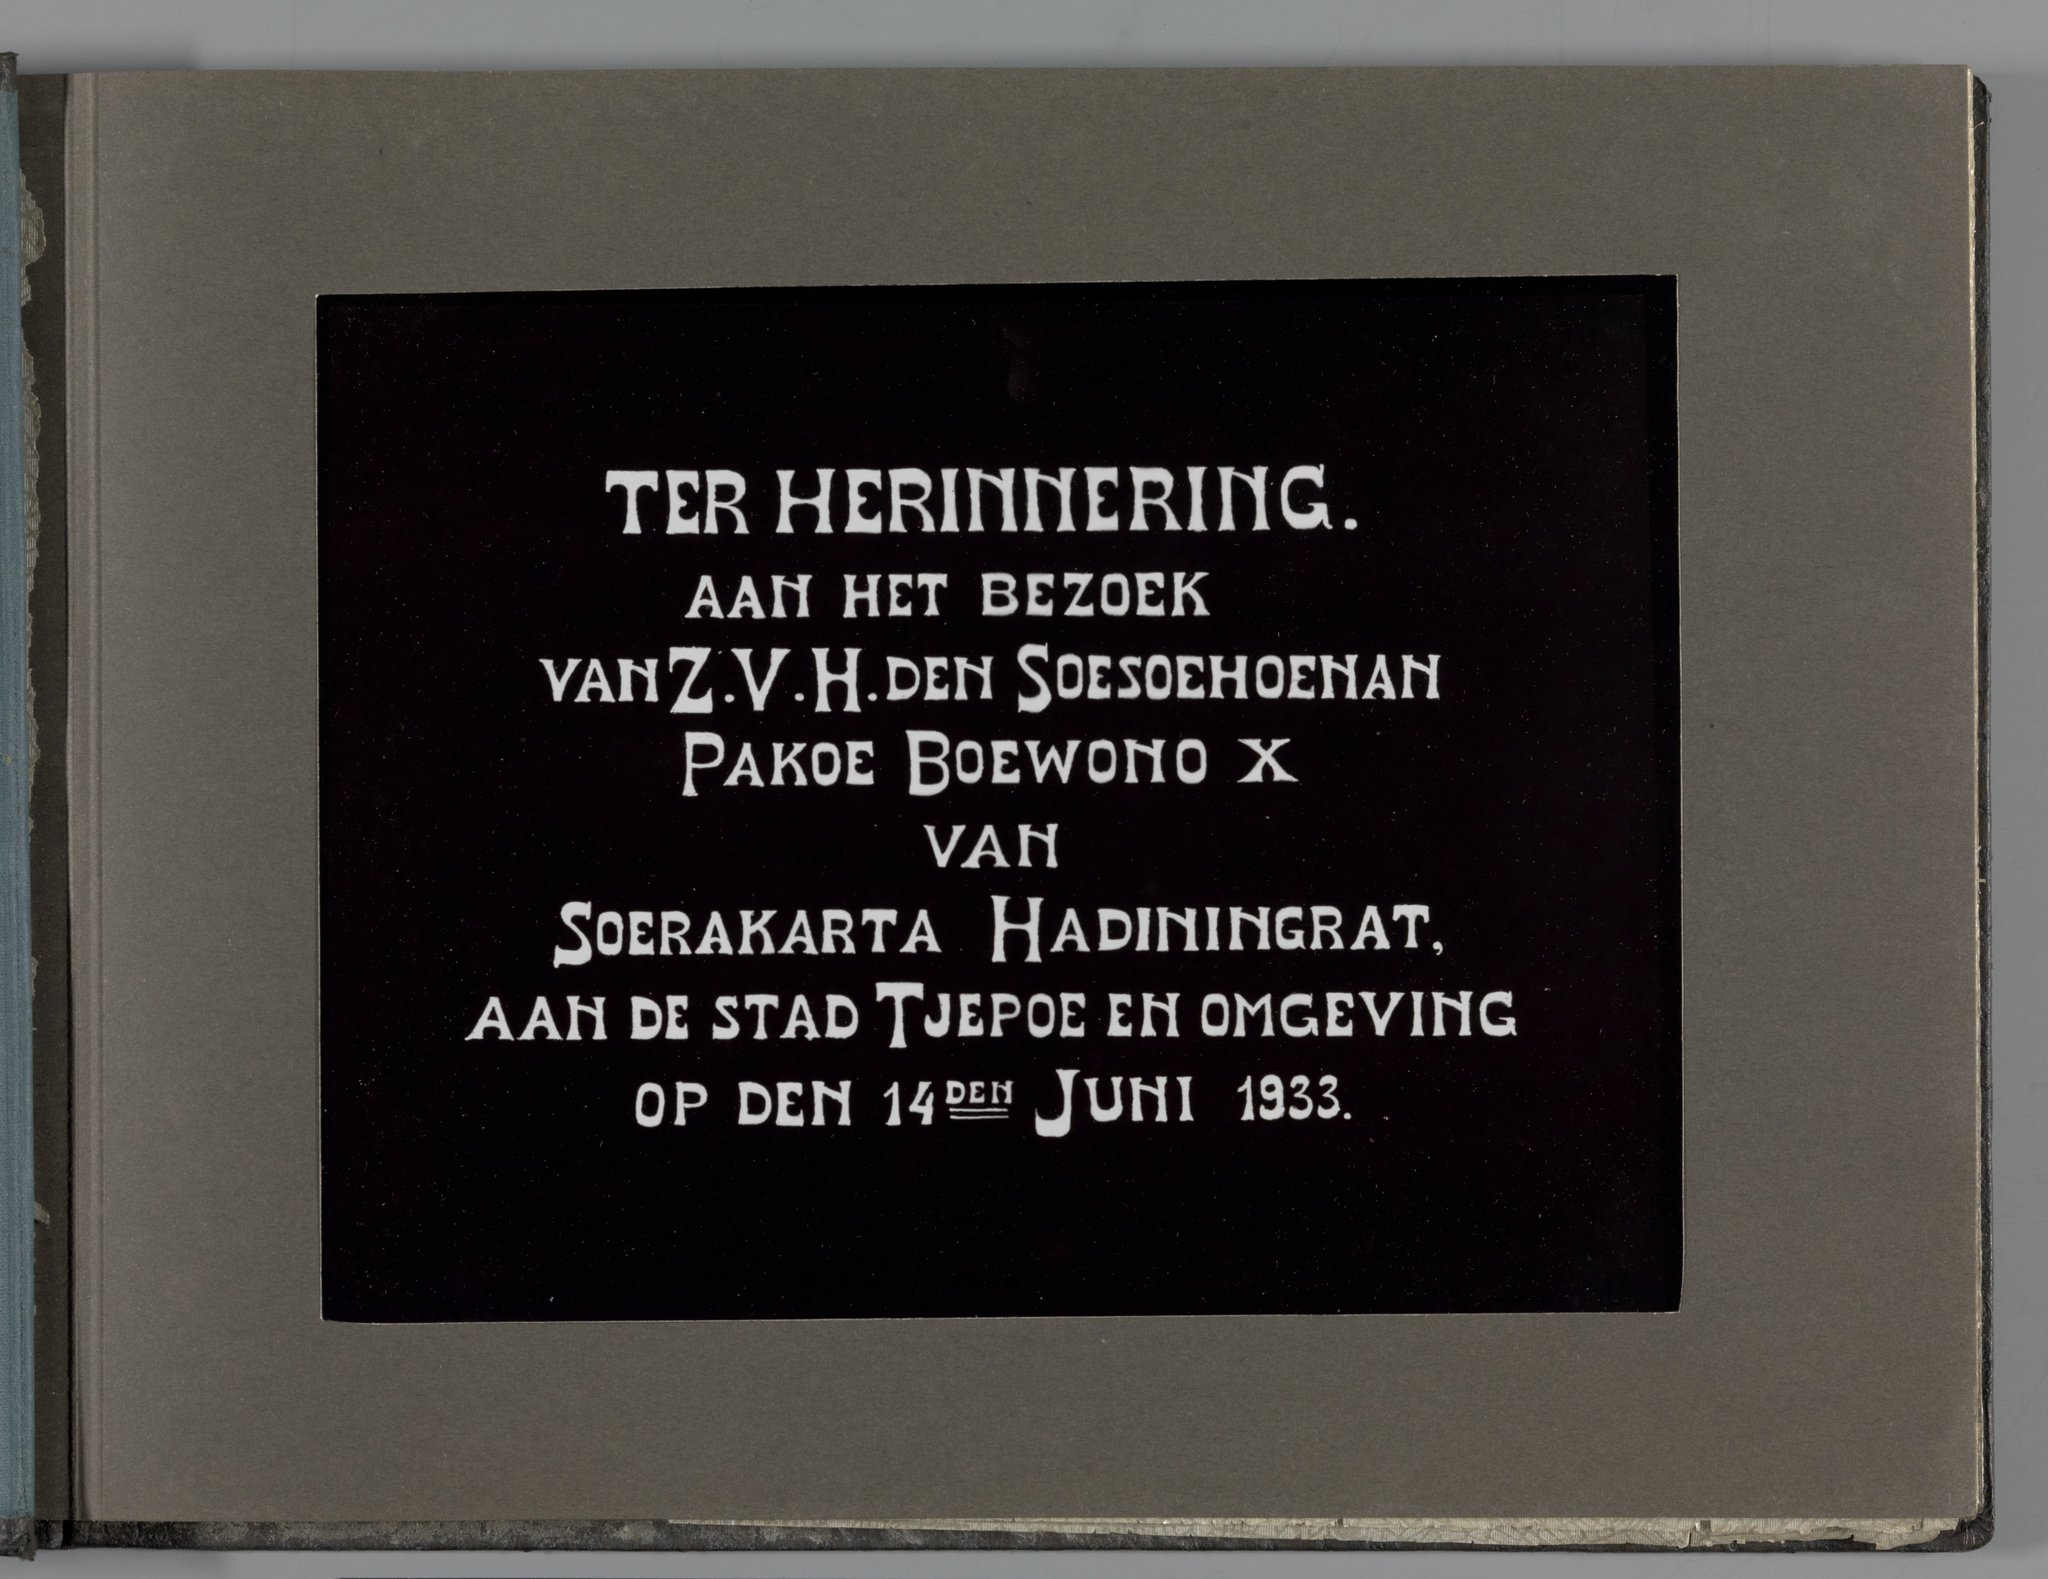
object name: photograph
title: Titelpagina in het fotoalbum ter herinnering aan het bezoek van de Soesoehoenan Pakoe Boewono X van Soerakarta Hadiningrat aan Cepu en omgeving op 14 juni 1933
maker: Anonymous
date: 1933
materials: photographic support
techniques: photography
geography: java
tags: colonial government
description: Titelpagina met tekst in het fotoalbum met 14 foto's ter herinnering aan het bezoek van de Soesoehoenan Pakoe Boewono X van Soerakarta Hadiningrat, aan Cepu (Tjepoe) en omgeving op 14 juni 1933. Fotografisch gereproduceerd onderschrift van een witte handgeschreven tekst met een zwarte ondergrond.